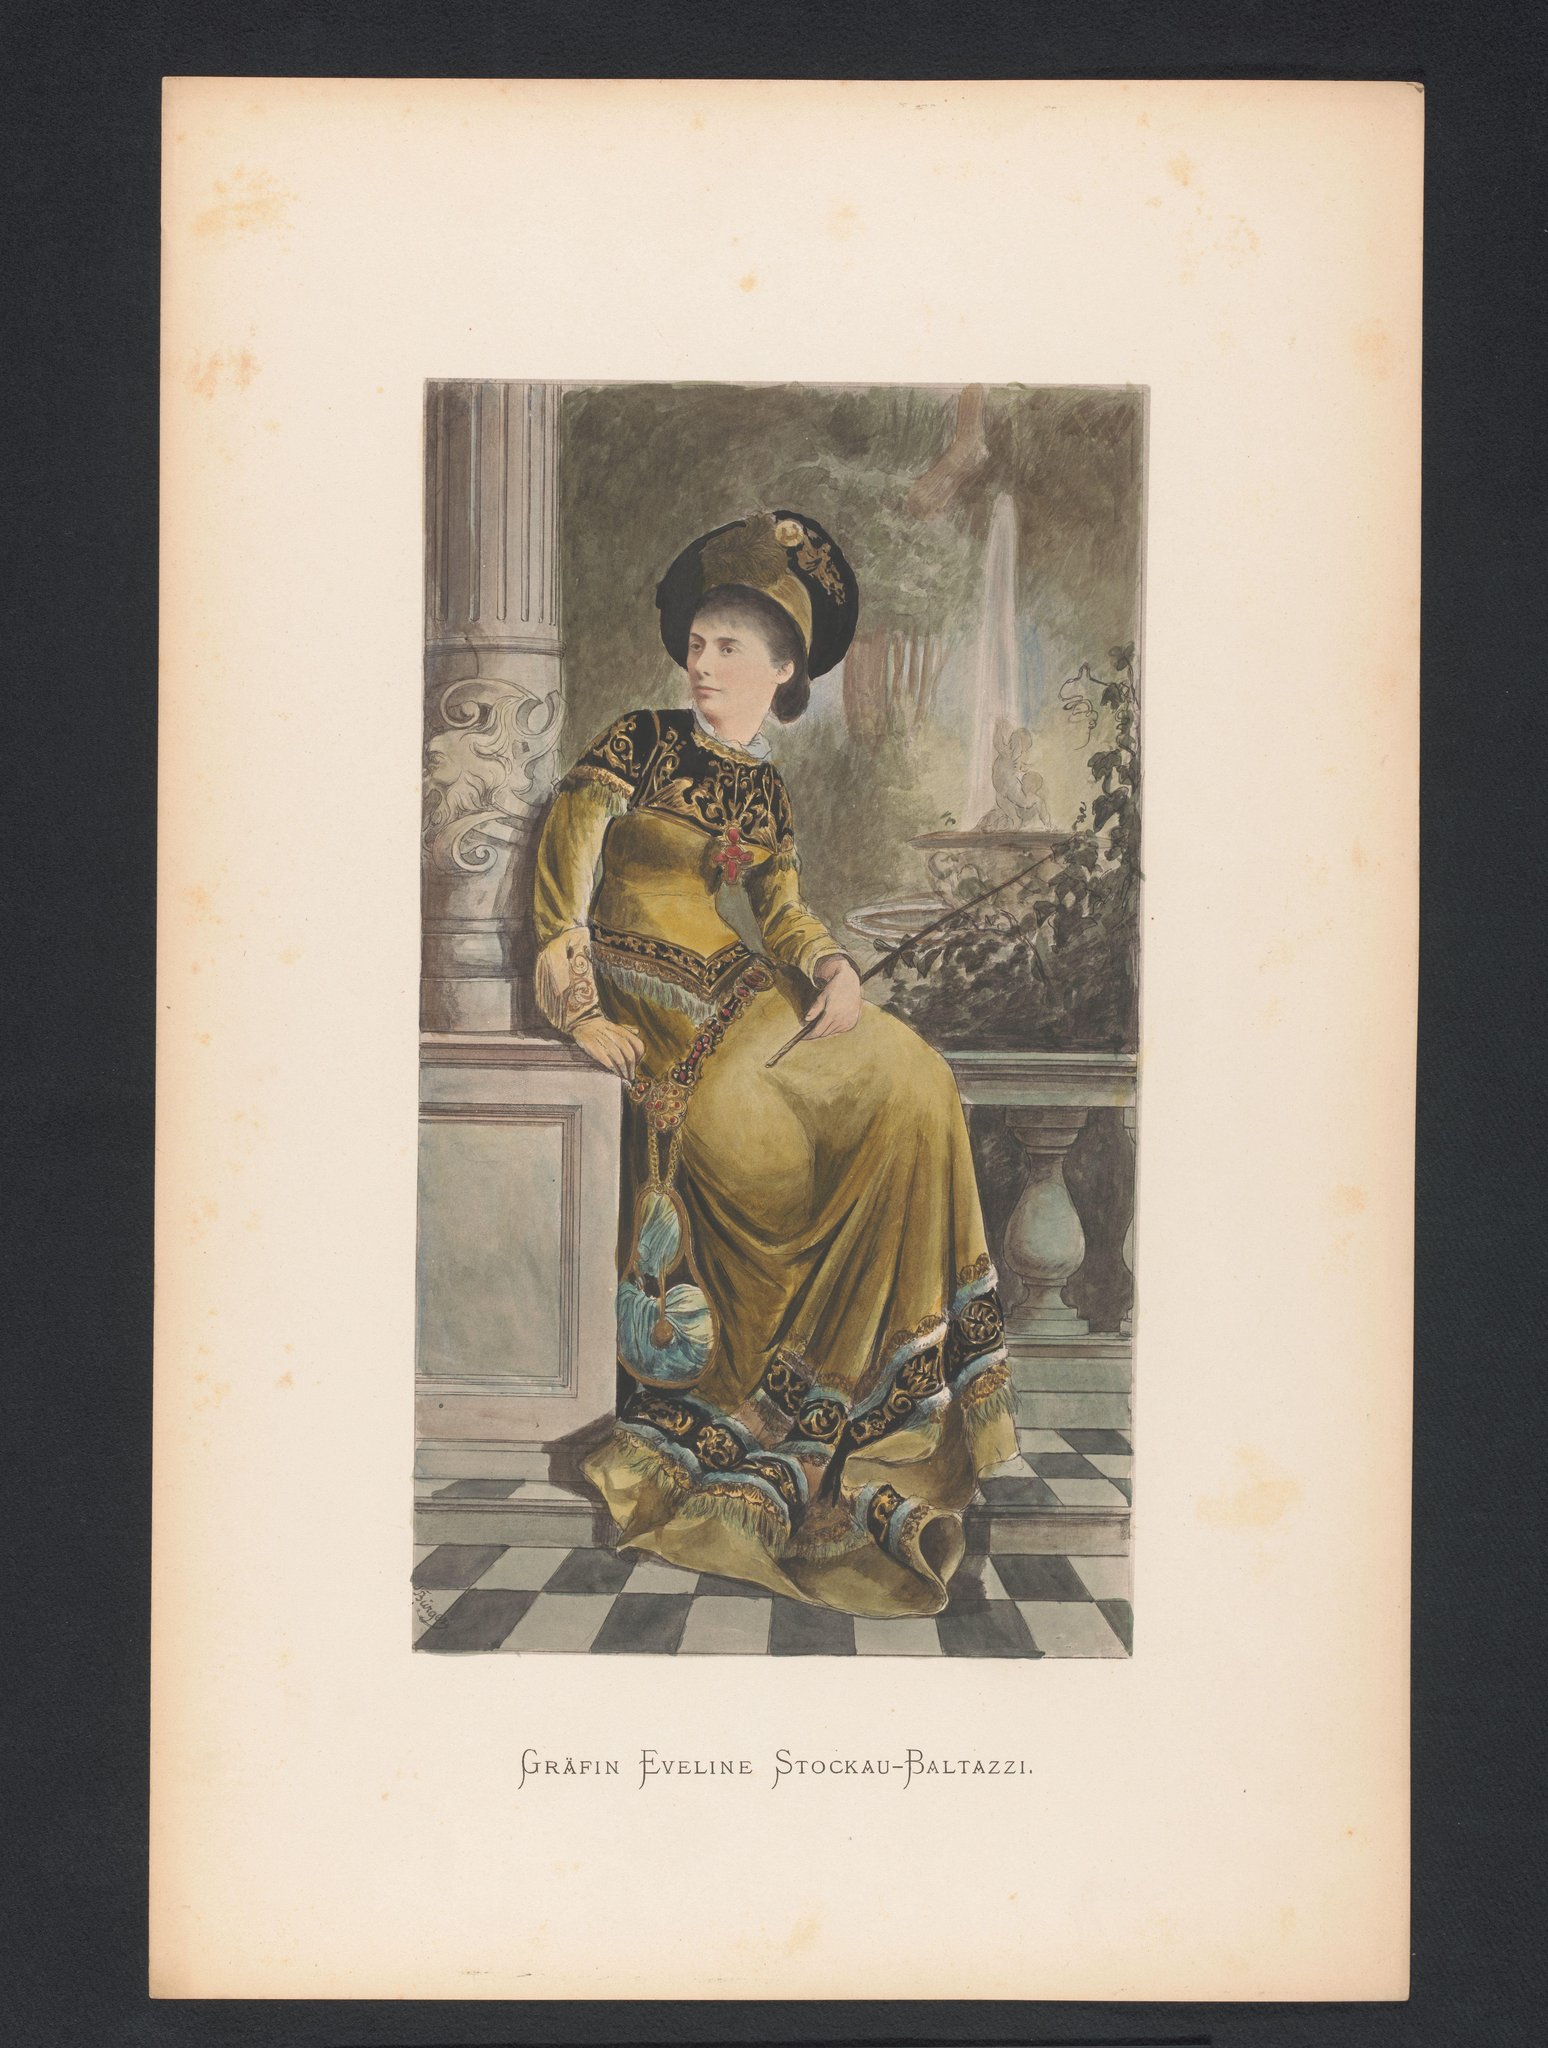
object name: photomechanical print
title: Gräfin Eveline Stockau-Baltazzi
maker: Anonymous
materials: paper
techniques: photograph, hand coloring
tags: historical persons - bb - woman, aristocracy; 'aristocratia' (ripa)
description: Deze prent maakt deel uit van een omslag met 86 prenten op 78 bladen en 11 tekstbladen.